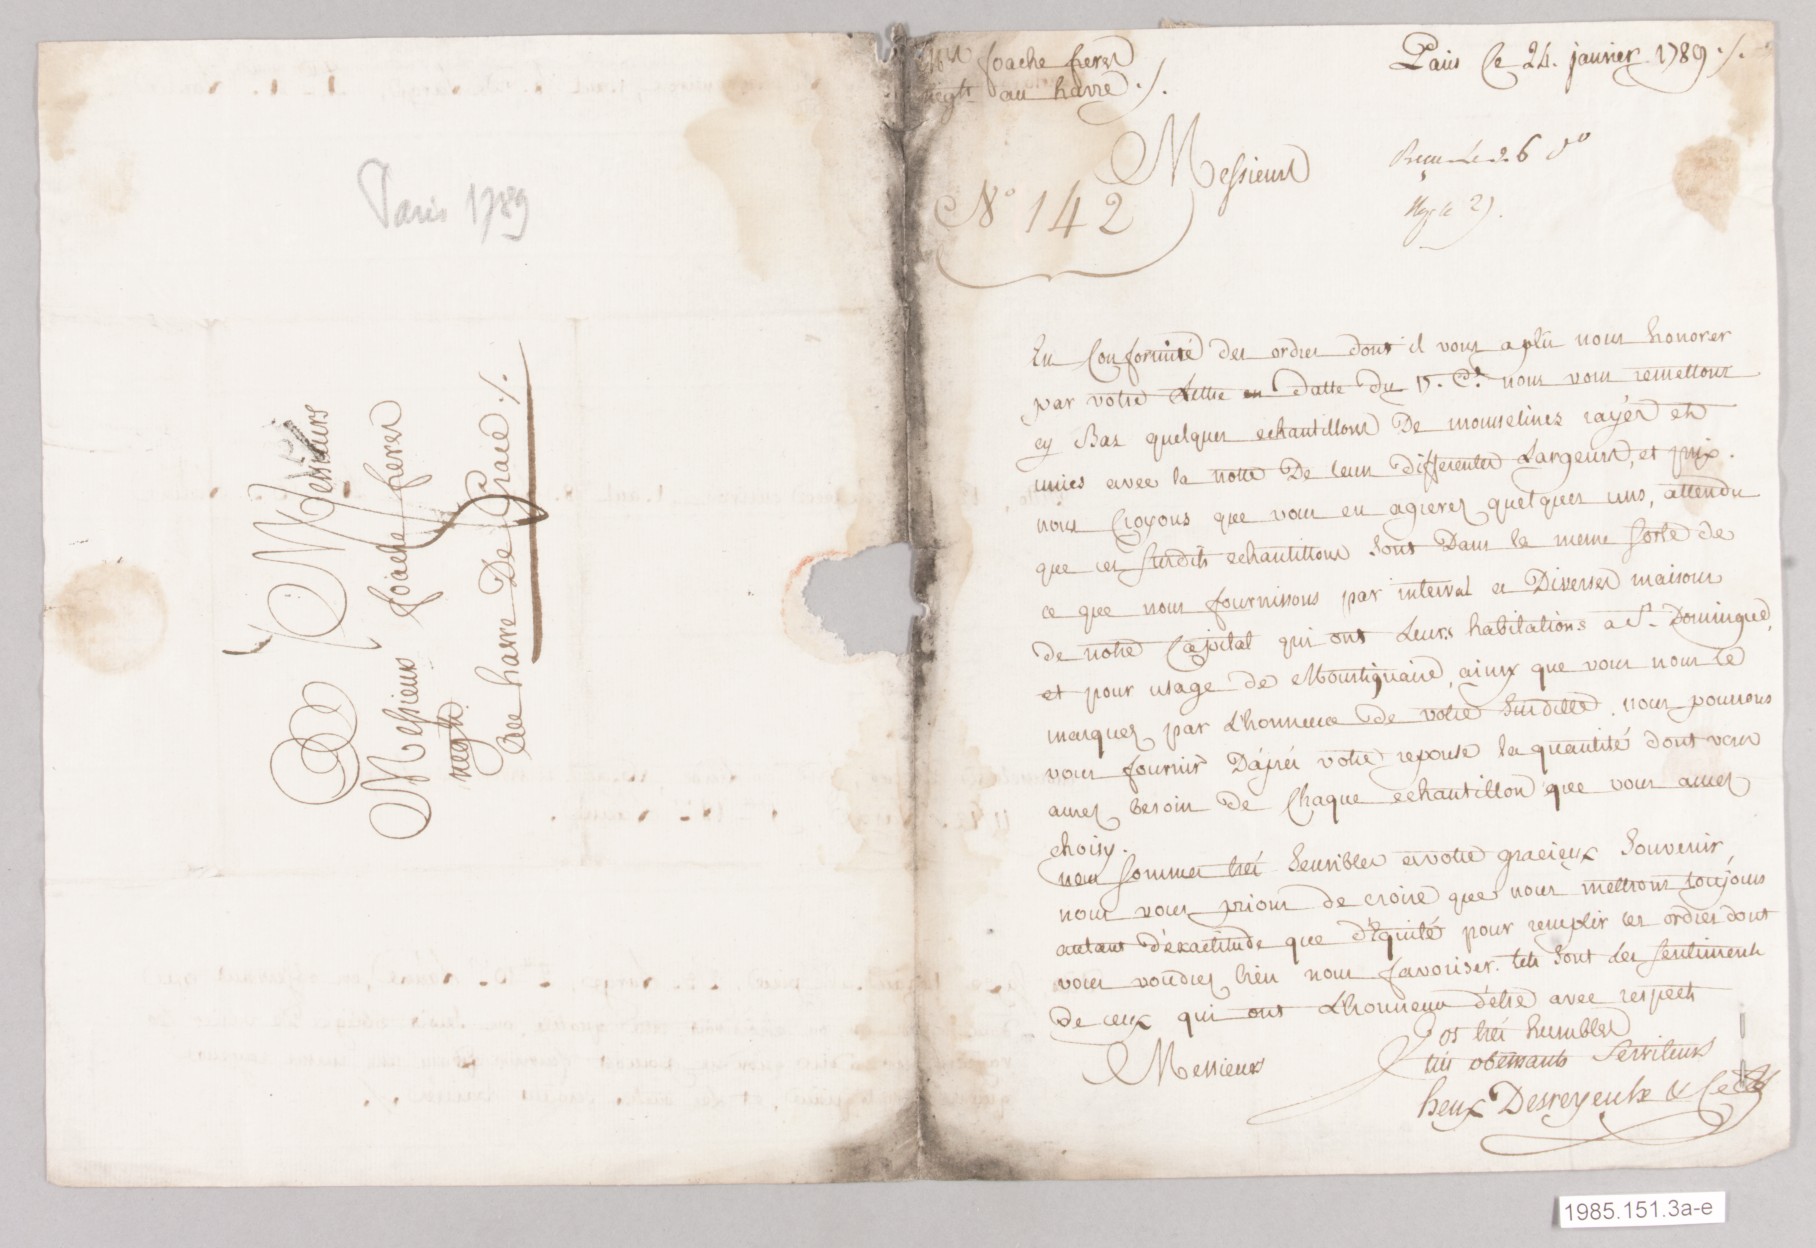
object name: letter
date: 1767-1800